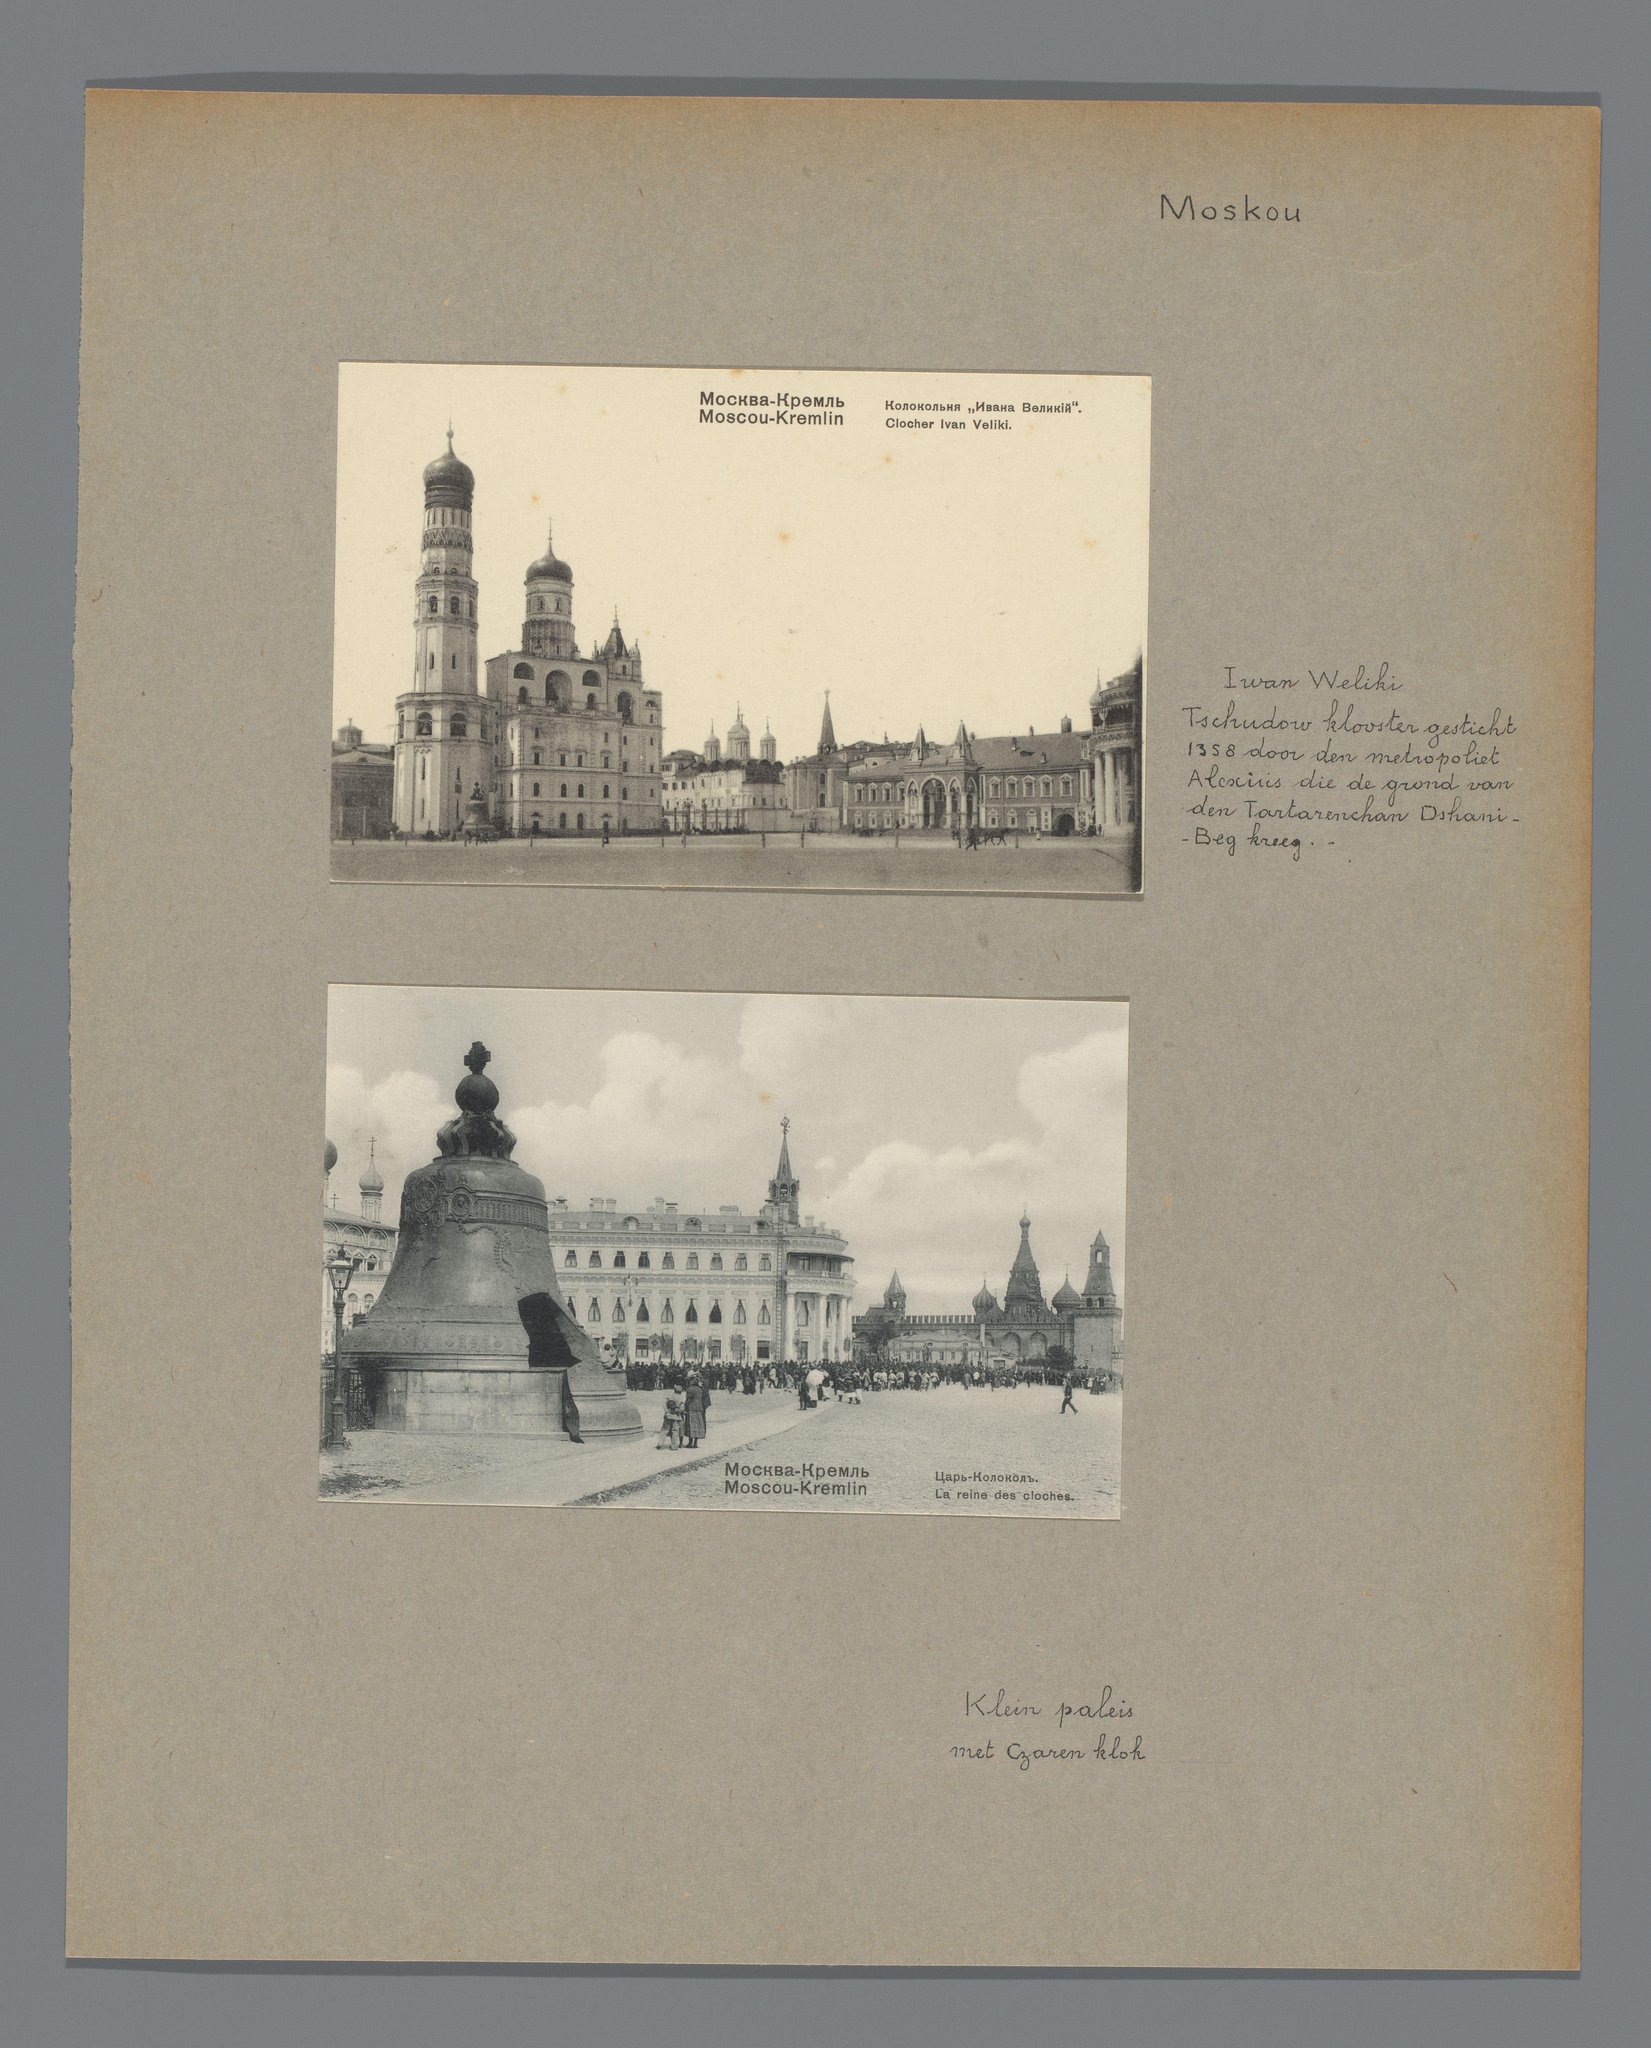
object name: photograph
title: Moskou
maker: Anonymous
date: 1860-1925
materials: photographic support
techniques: photograph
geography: russia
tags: moskou